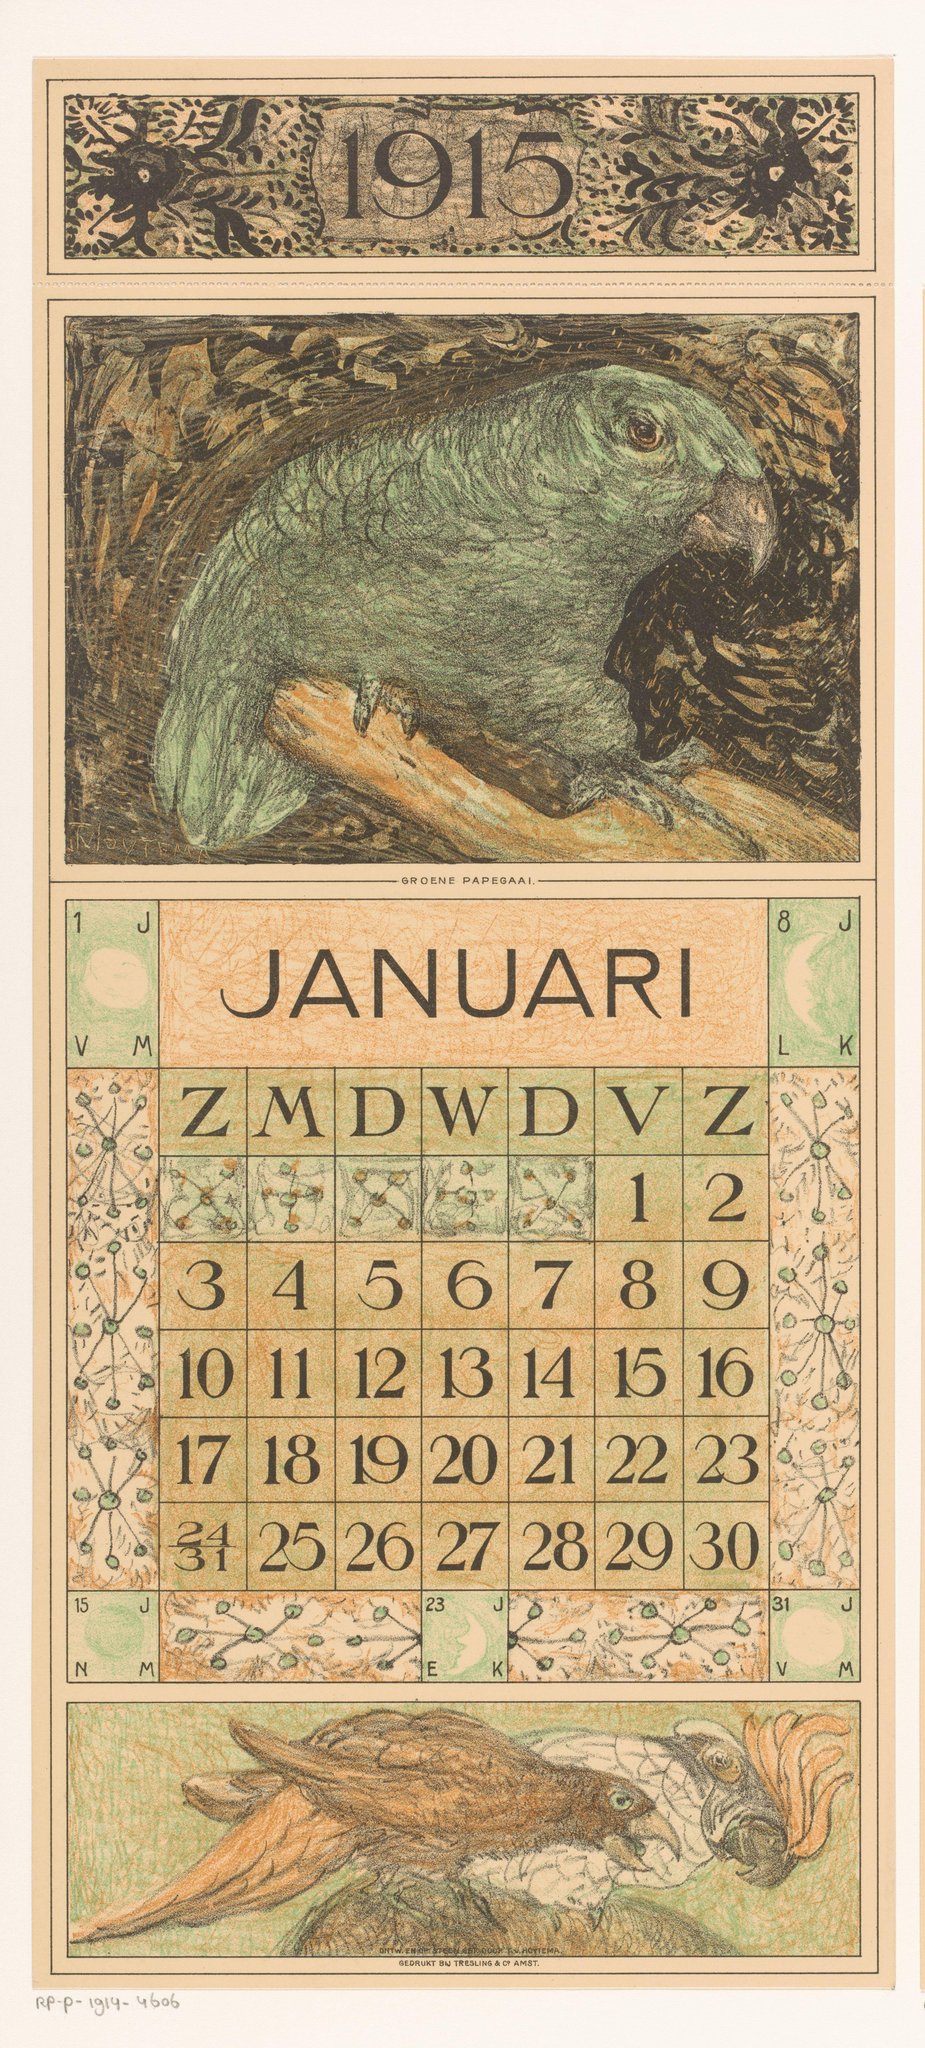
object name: calendar leaf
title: Kalenderblad januari met papegaai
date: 1914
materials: paper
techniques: lithograph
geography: amsterdam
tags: lunar year, ornamental birds: parrot, ornamental birds: cockatoo, january ~ other concepts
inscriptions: collector's mark: Lugt 2233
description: De papegaai zit op een tak. Onderin een oranje papegaai en een witte kaketoe. In de hoeken de standen van de maan op vier dagen. Onder het jaartal een scheurlijn.